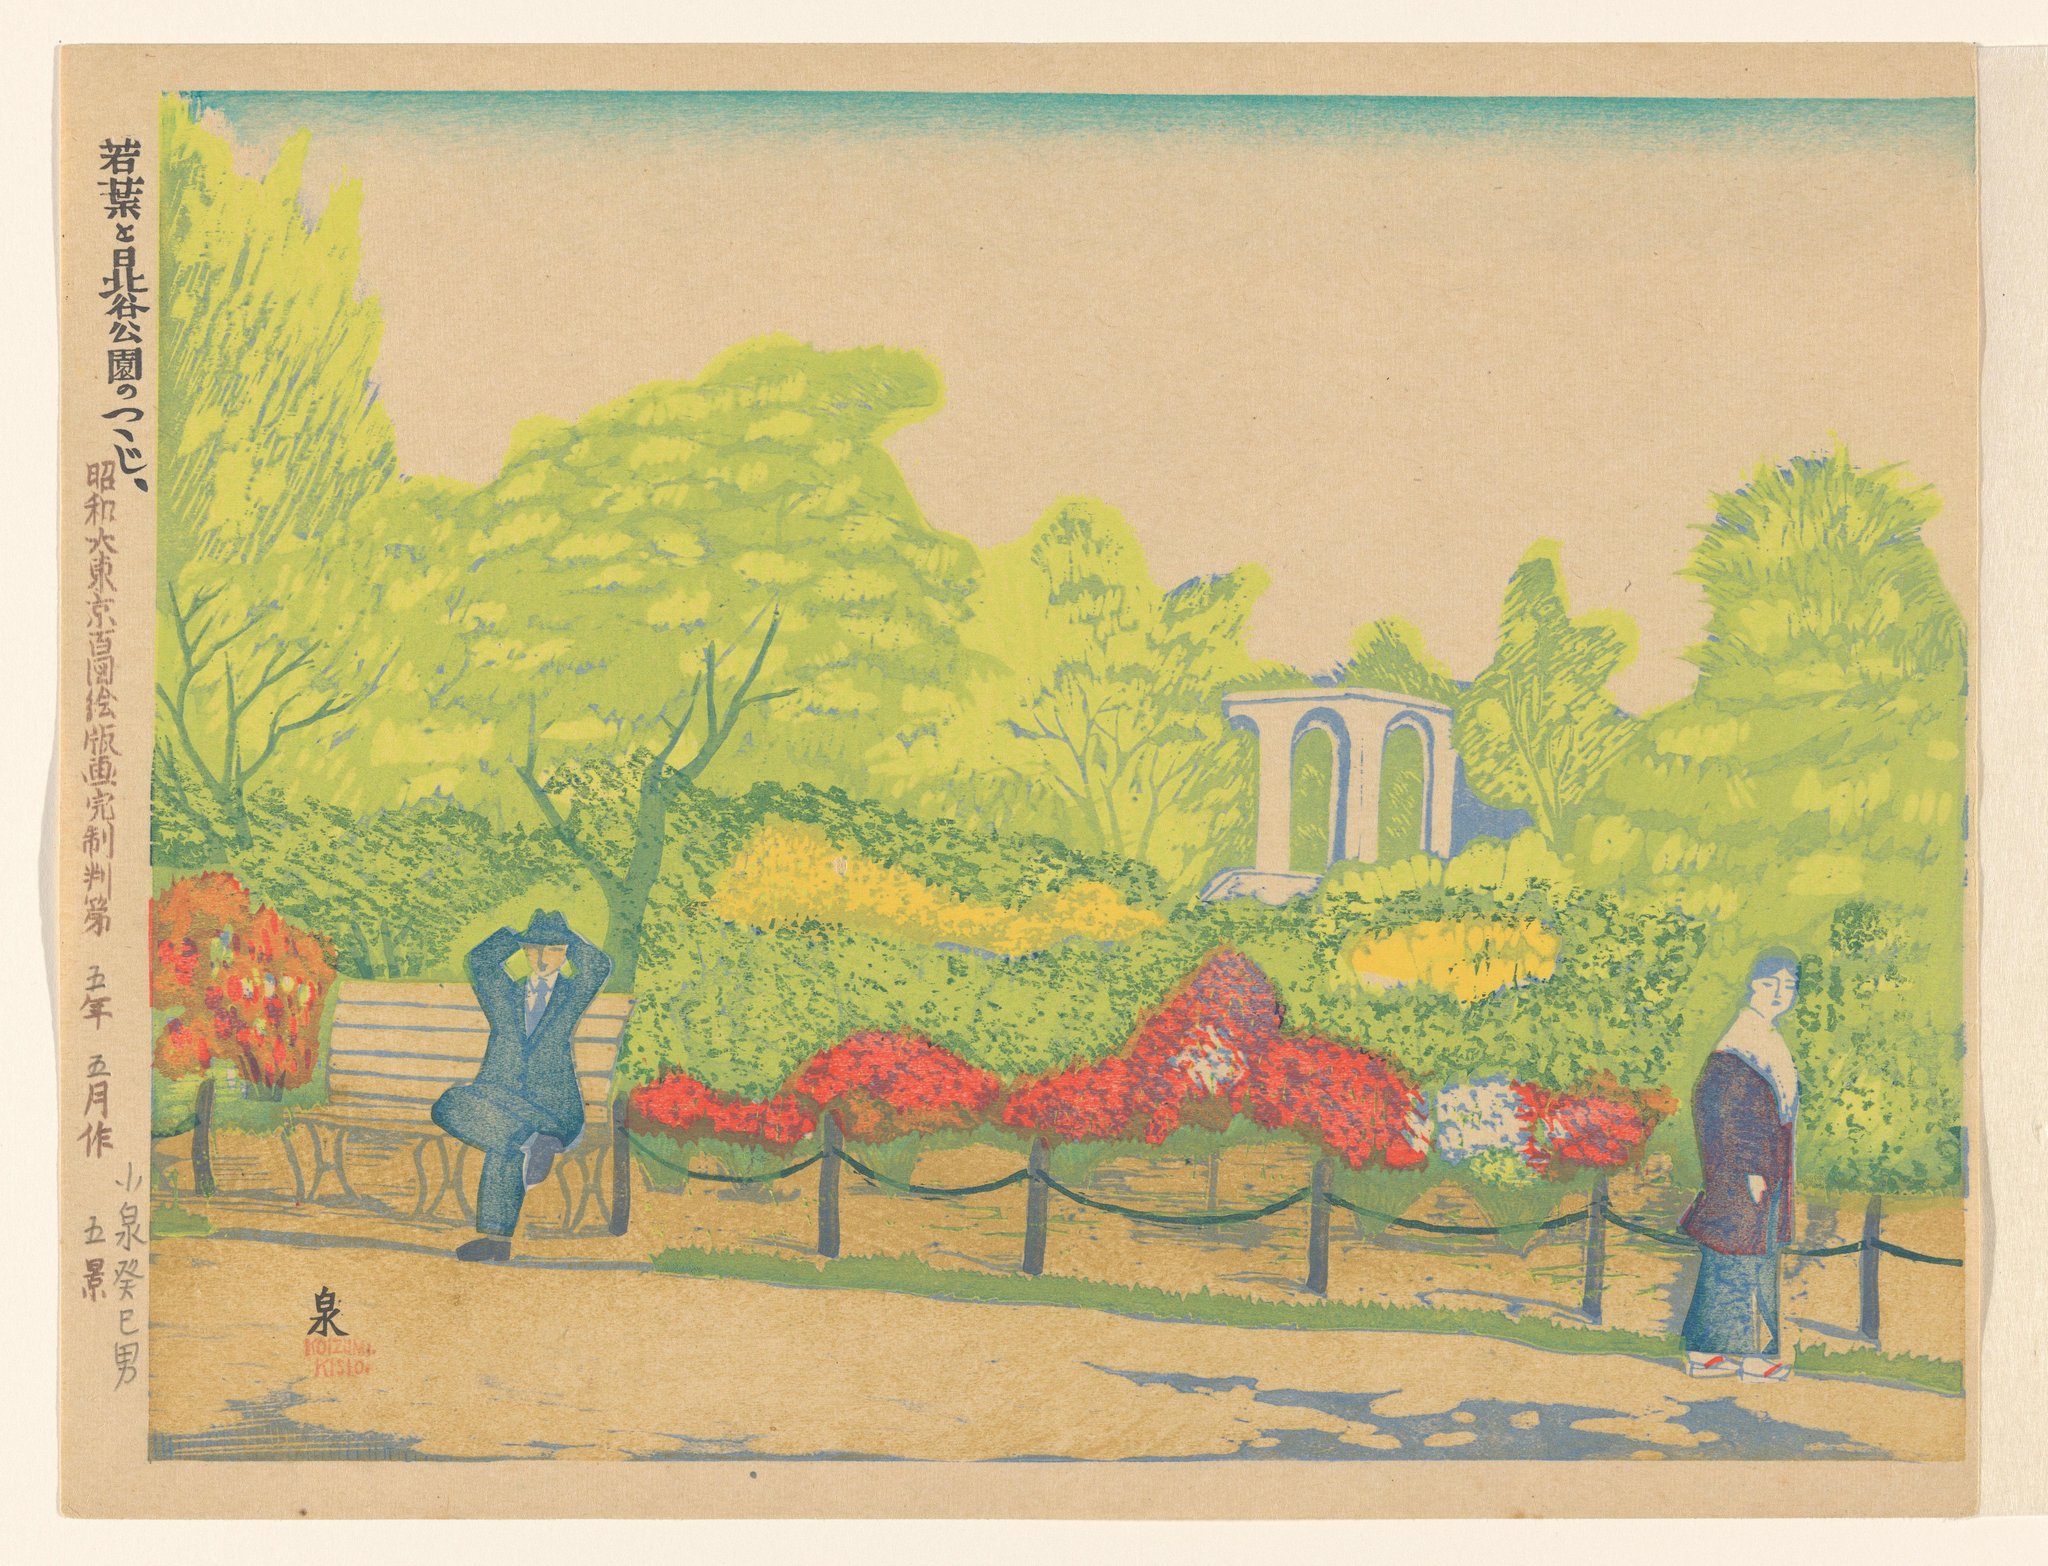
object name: print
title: Wakaba to Hibiya kōen no tsutsuji gokei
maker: koizumi kishio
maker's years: 1893-1945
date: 1905-1930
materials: paper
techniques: woodcut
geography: japan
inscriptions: signature: ‘泉’, signature: ‘Koizumi Kisio.’, signature: ‘小泉癸巳男’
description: Een man zit uit te rusten op een bankje in het Hibiya-park in Tokyo. Rechts loopt een vrouw in een kimono en bruine overjas, ze kijkt om naar de toeschouwer. Tussen de felgroene bomen en struiken bloeien rode azalea's. In september 1928 begon Koizumi Kishio aan zijn ambitieuze plan om honderd landschapsprenten met scènes in Tokyo volledig zelf te ontwerpen, hiervan zelf de drukblokken te snijden en zelf de prenten te drukken. De aanleiding voor het project was grote verandering die Tokyo onderging door de verwoestende Grote Kantō-aardbeving van 1923 en de wederopbouw die daarop volgde. Kishio maakt een bewuste verwijzing naar de bekende serie ‘Honderd beroemde gezichten op Edo’ door Utagawa Hiroshige (1797–1858), met prenten van locaties in Edo—de oude benaming voor Tokyo. Kishio toont overwegend moderne gebouwen, instituten en mensen die de tijdsgeest van de jaren 1920 en 1930 weerspiegelen. Sommige prenten onthullen daarentegen een nostalgische blik op overblijfselen uit het oude Edo. Kishio verkocht de prenten aan de hand van een abonnement met een limiet van vijftig leden, die elke maand een of twee prenten zouden ontvangen. Het project begon met negen abonnementen, maar al na de tweede maand werden meerdere daarvan opgezegd en slechts vier mecenassen bleven lid tot en met de voltooiing van de serie. Hij bracht het honderdste ontwerp uit in 1937. Zijn leermeester Ishii Hakutei schreef een inleiding in 1938 die Kishio verwerkte tot een prent en toevoegde aan de set. Tussen 1939 en 1940 maakte hij nog eens negen extra ontwerpen. Met acht van deze ontwerpen verving hij oudere nummers uit de serie, mogelijk omdat hij niet tevreden was met de composities. Uiteindelijk lukte het Kishio om tien complete sets te verkopen aan de shin hanga-uitgever Watanabe Shōzaburō en liet hiervoor speciale houten dozen maken. Deze prent behoort tot een van die tien sets.